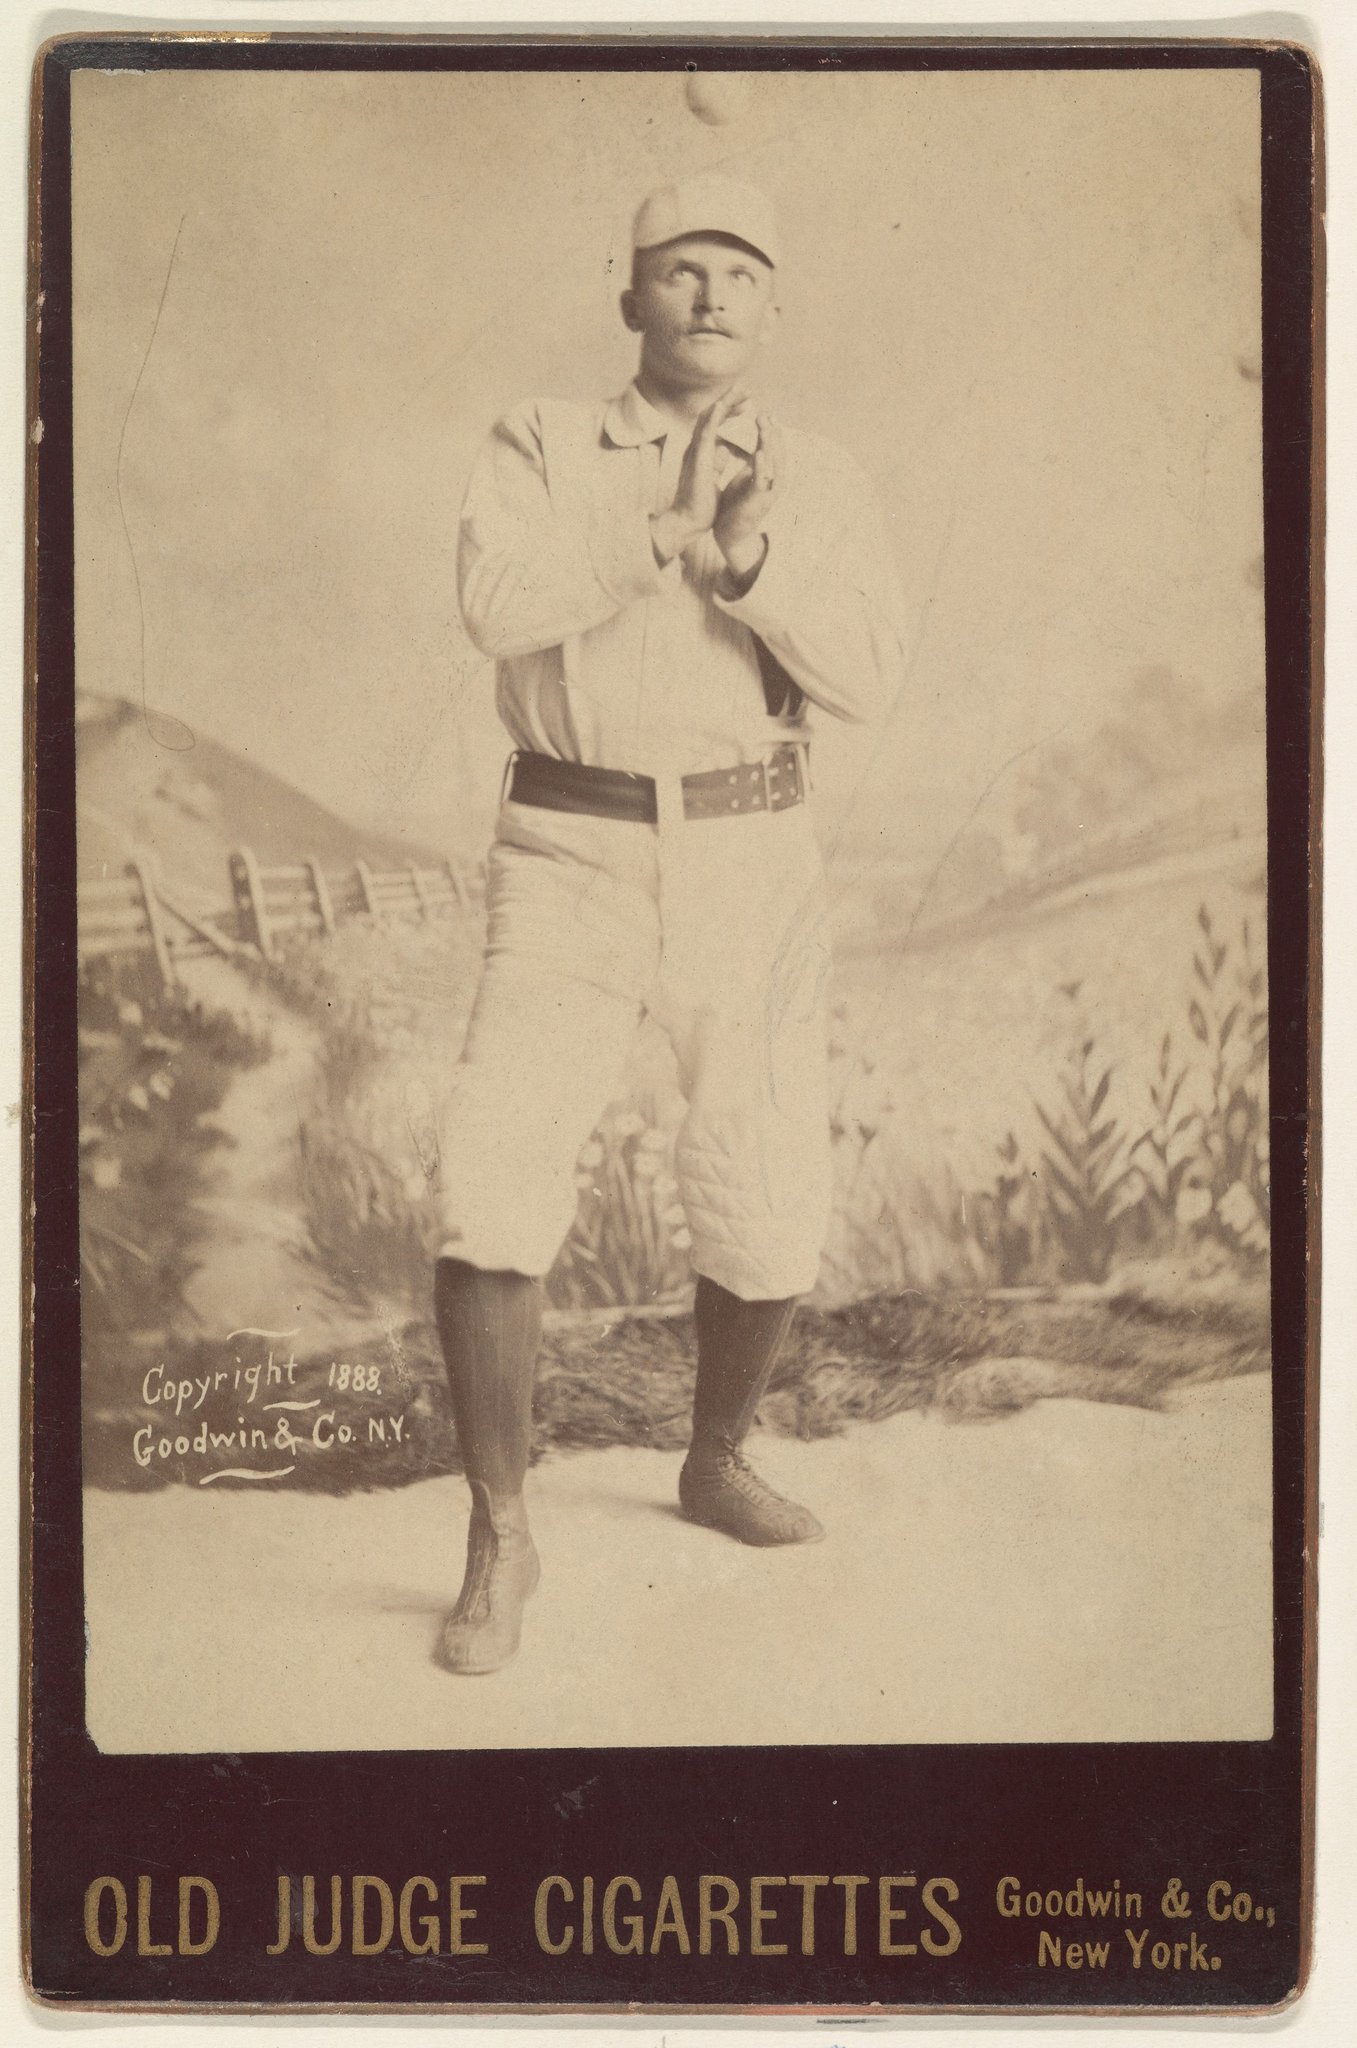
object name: baseball card, photograph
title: Wilmot, Washington, from the series Old Judge Cigarettes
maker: goodwin & company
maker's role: publisher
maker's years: 1850-1950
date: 1887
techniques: albumen print, photography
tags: men,portraits,baseball,athletes